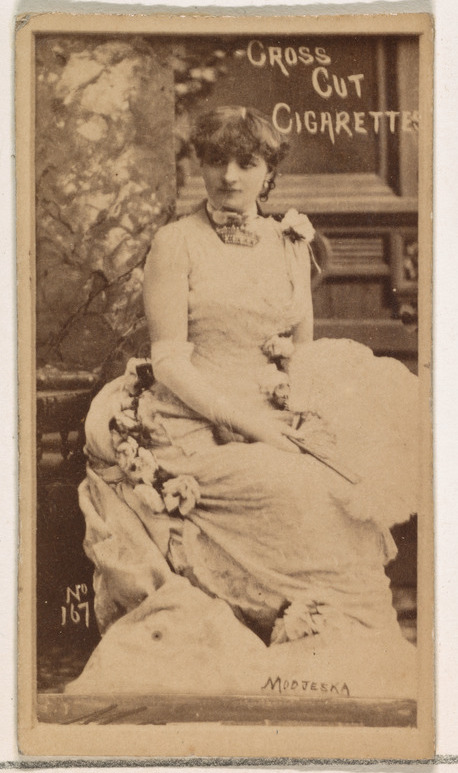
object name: print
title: Card Number 167, Modjeska, from the Actors and Actresses series (N145-1) issued by Duke Sons & Co. to promote Cross Cut Cigarettes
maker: w. duke, sons & co.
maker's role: publisher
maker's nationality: american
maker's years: 1870-1920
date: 1880-1889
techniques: albumen silver print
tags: portraits,women,actresses